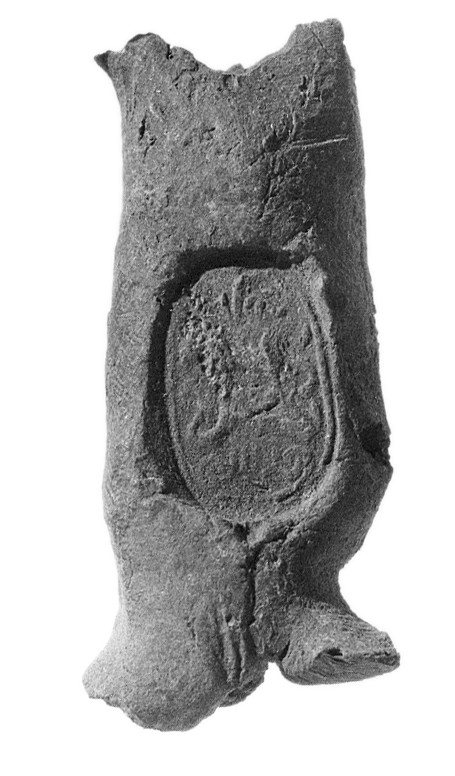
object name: sealing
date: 1981-1640 BCE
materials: clay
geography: egypt